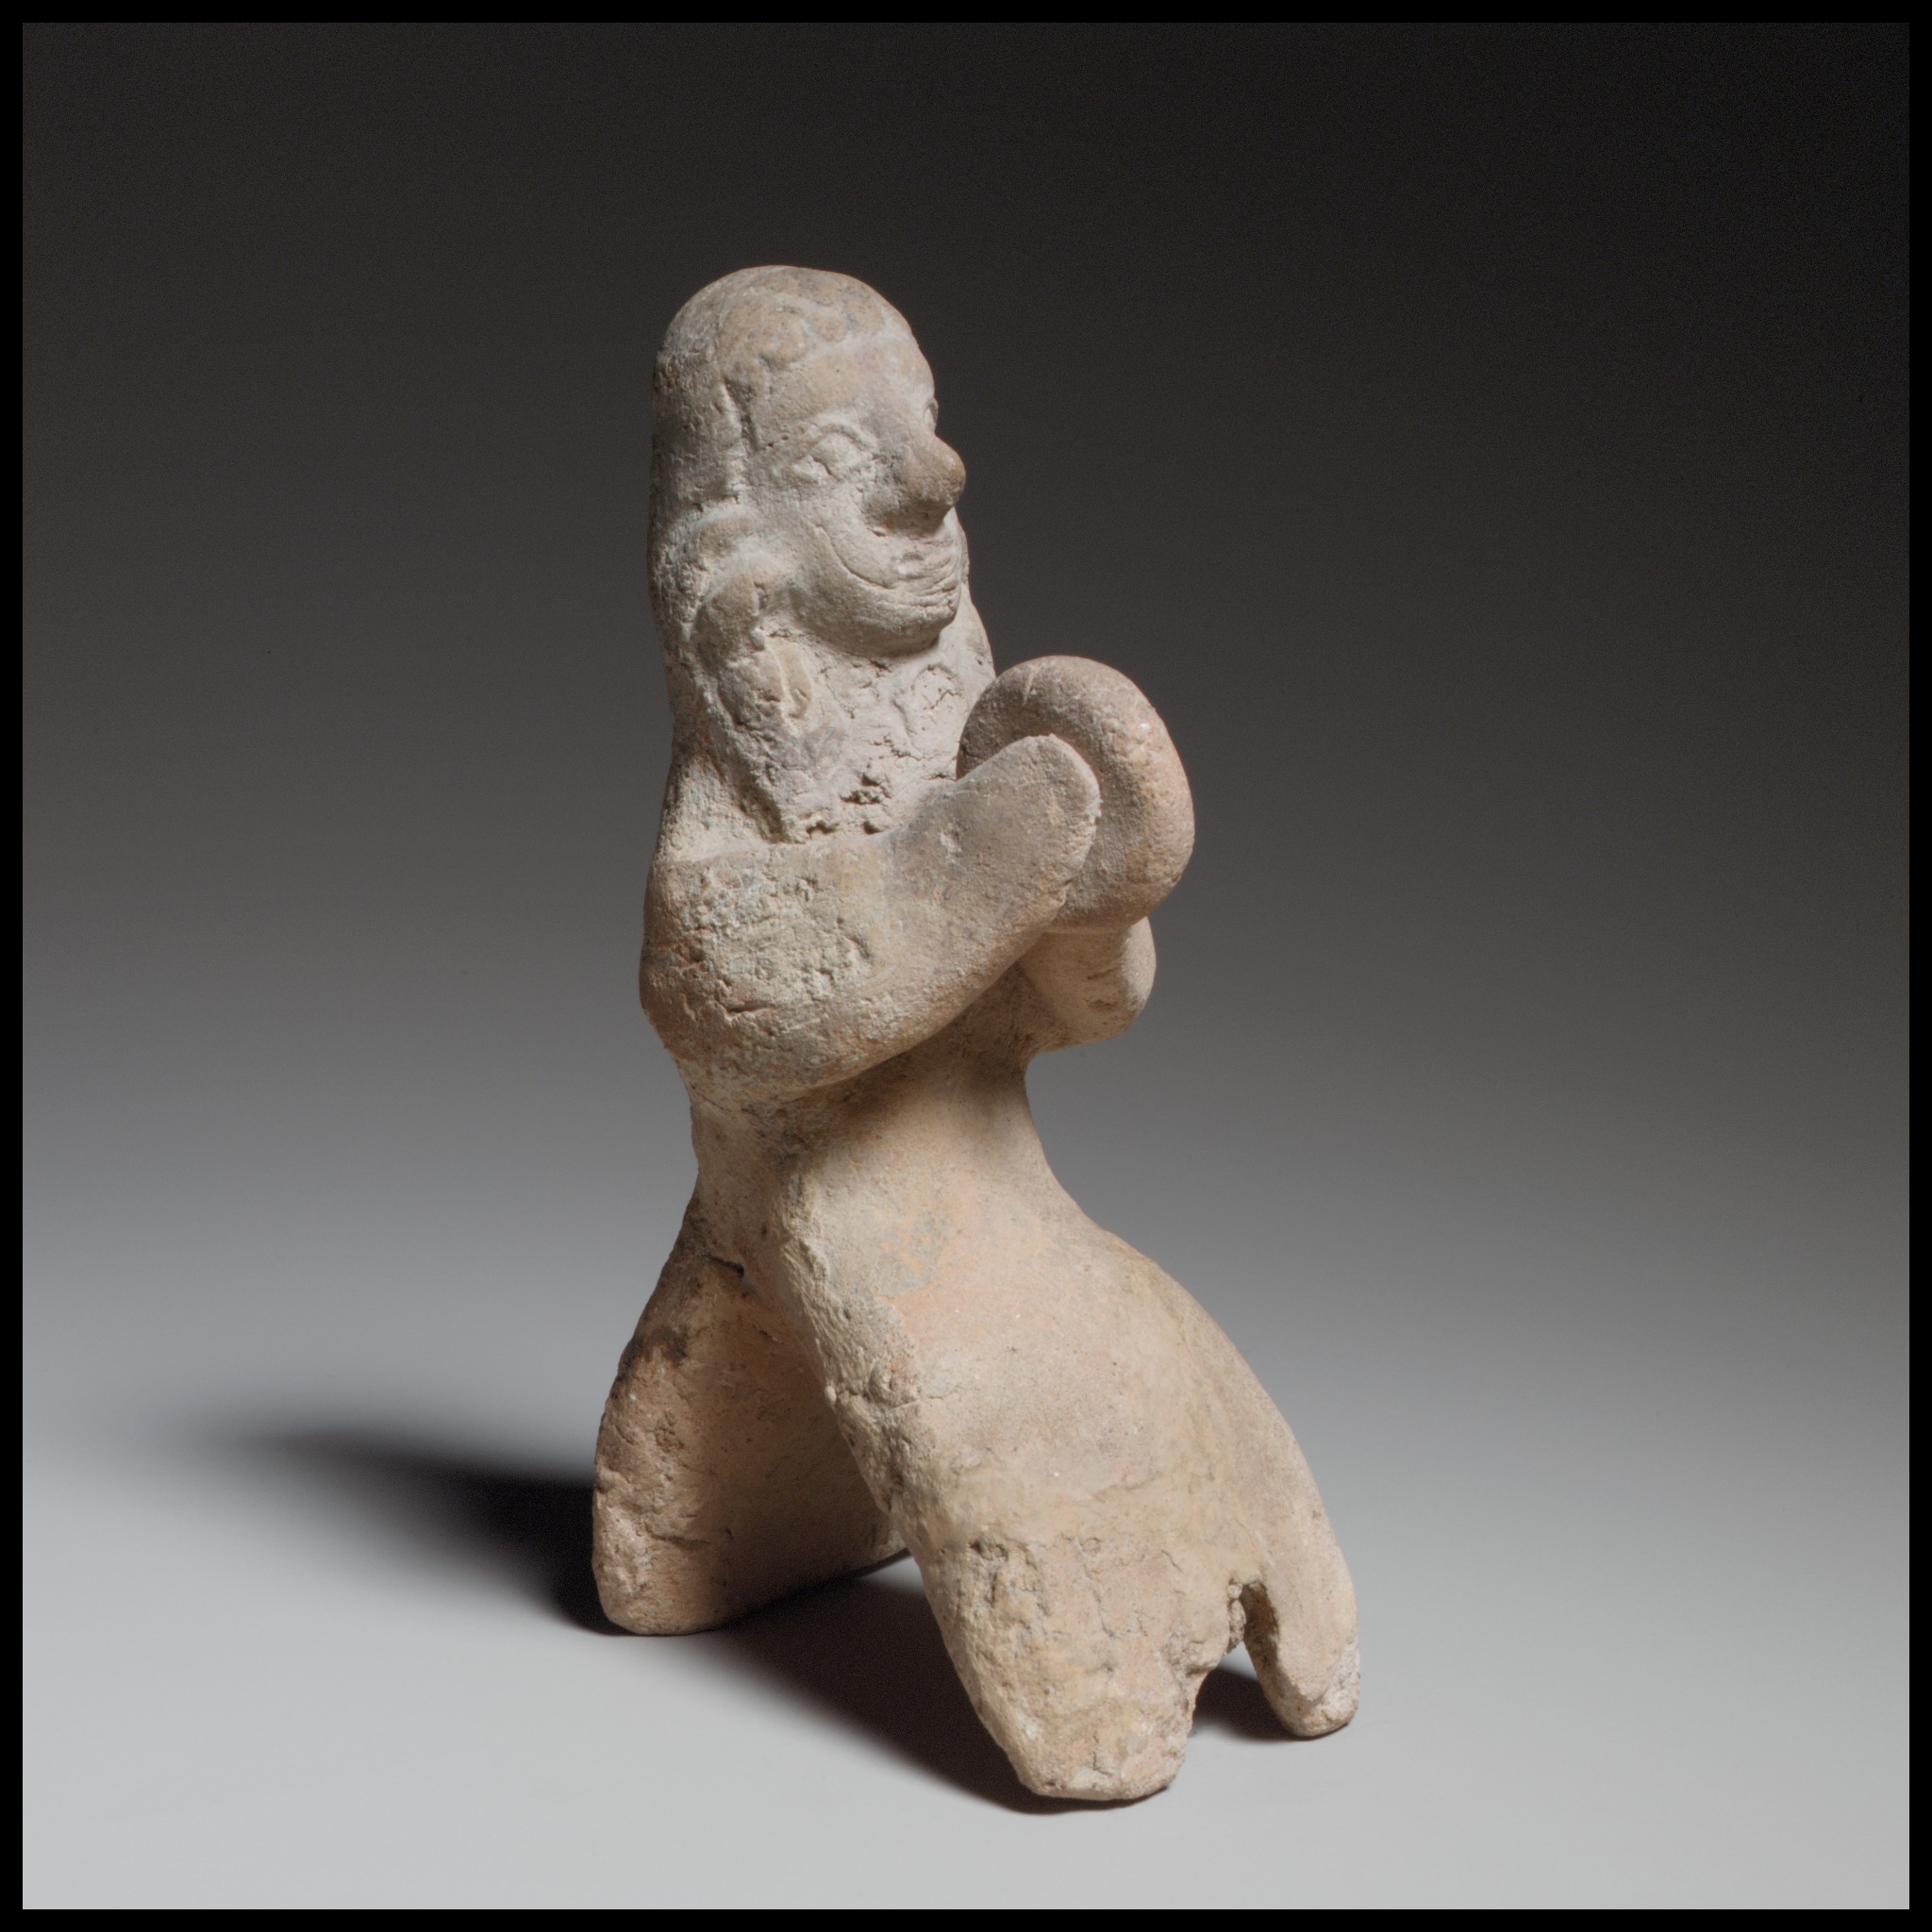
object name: statuette of a woman with tympanon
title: Seated female tambourine player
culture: cypriot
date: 600-480 BCE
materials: terracotta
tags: musical instruments,women,musicians